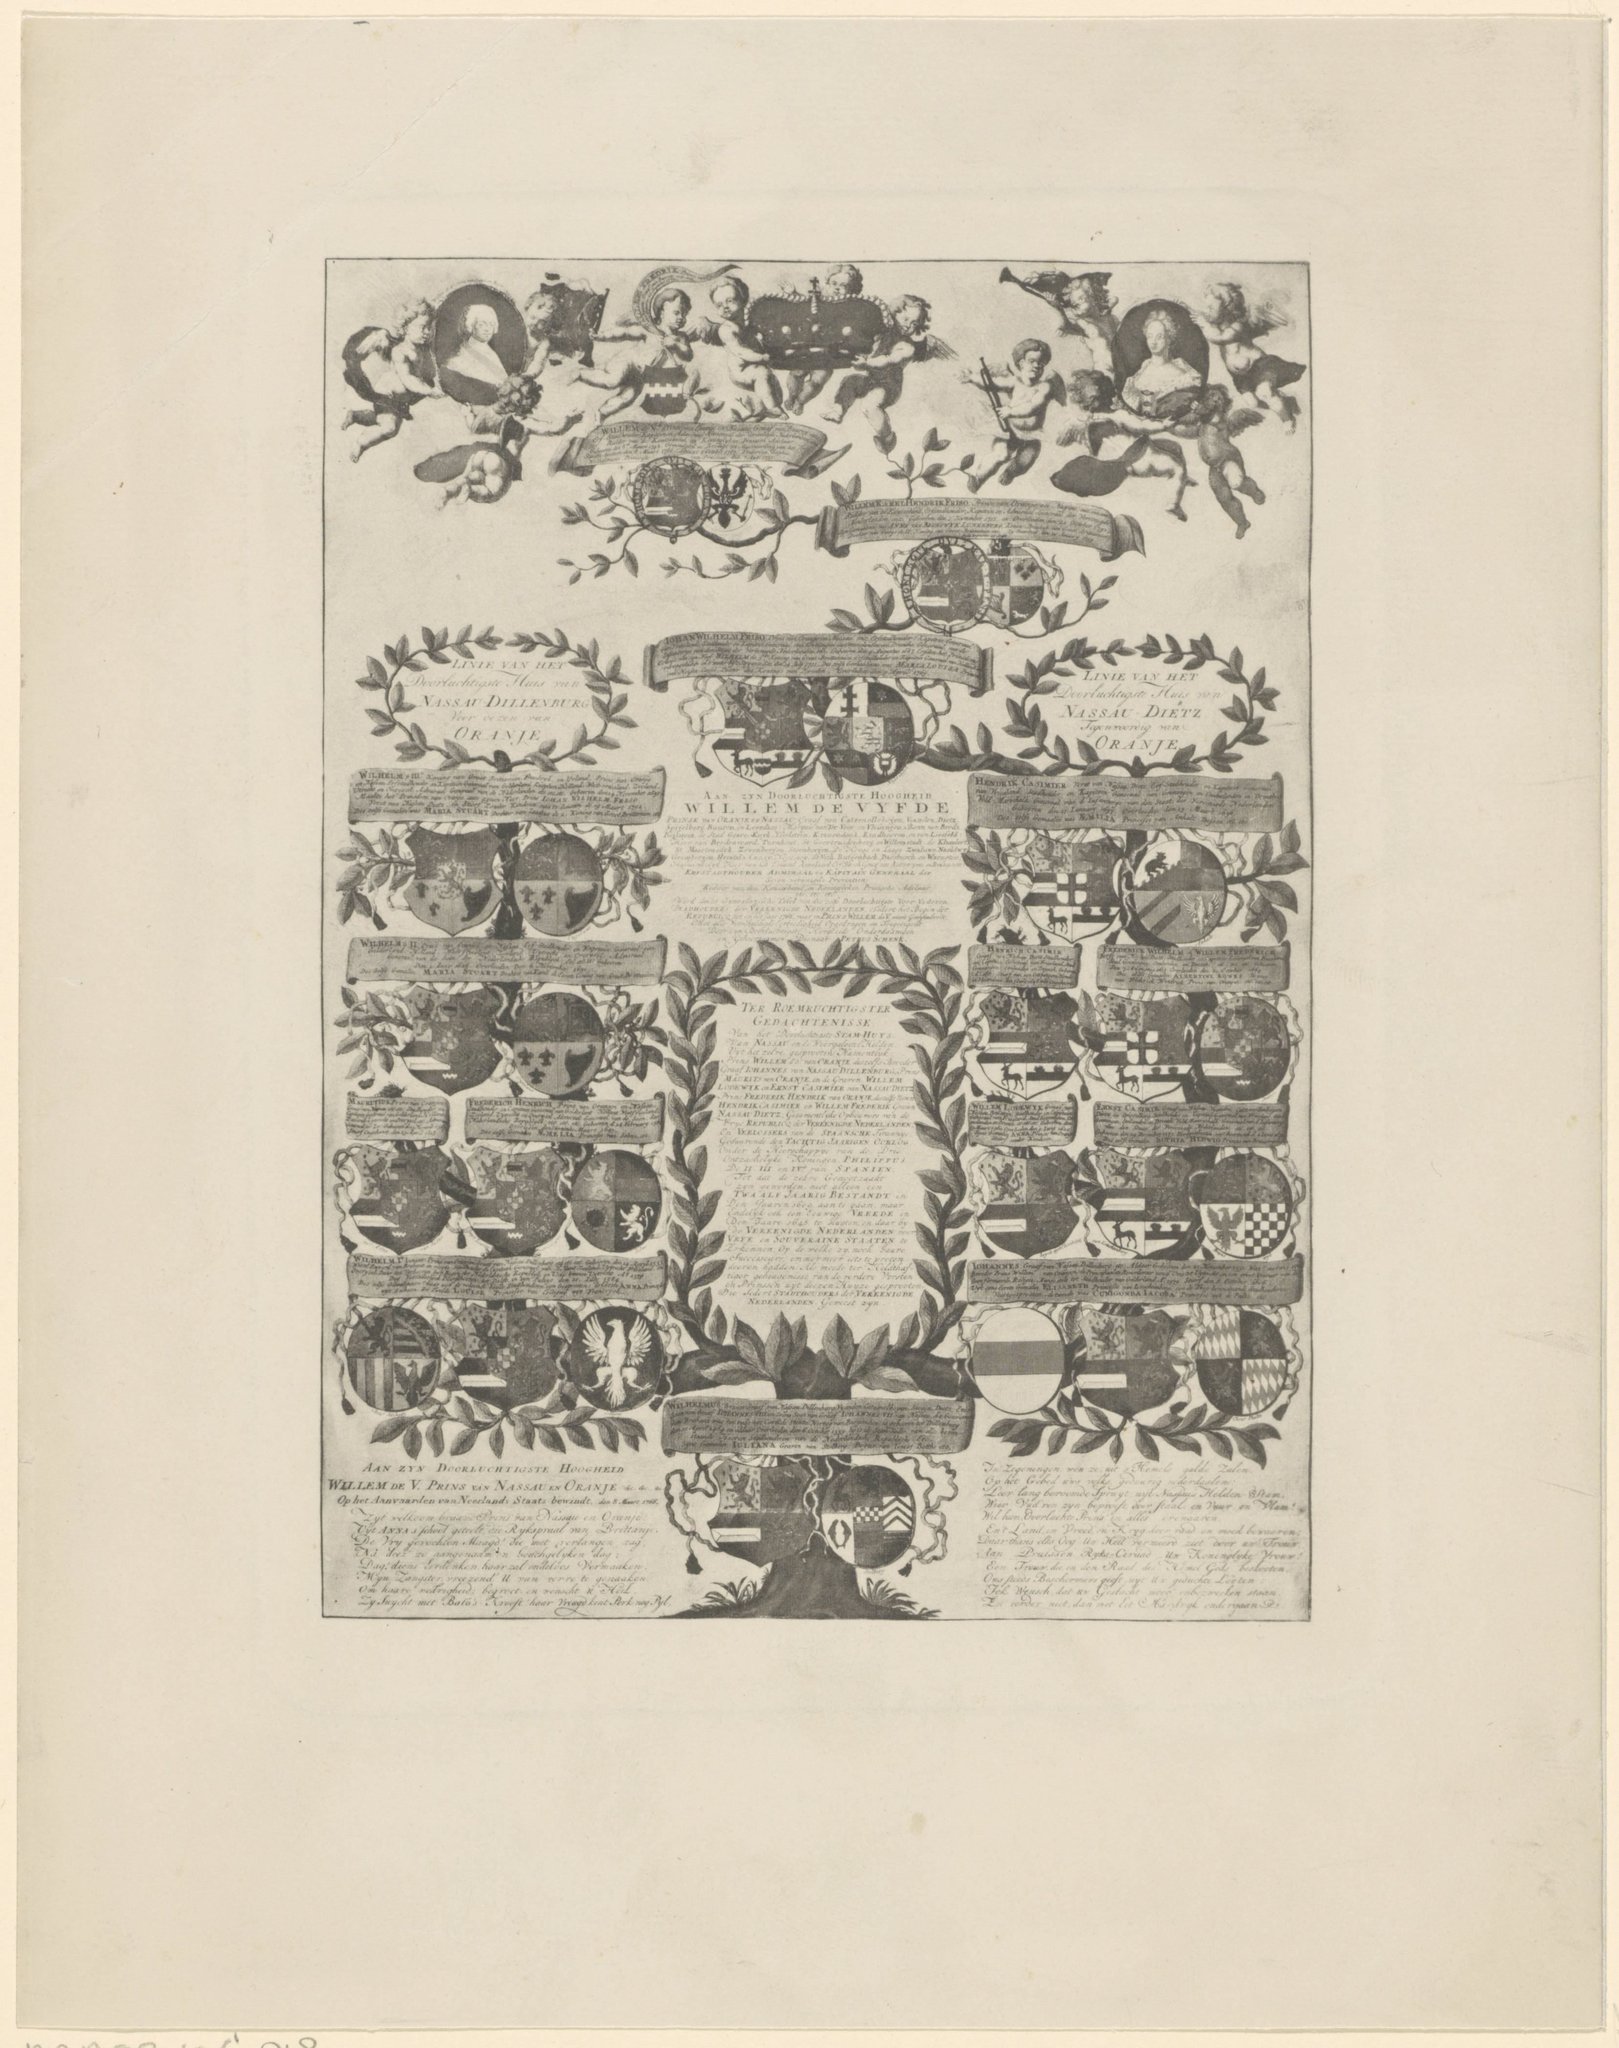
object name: photomechanical print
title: Stamboom van het Huis Oranje-Nassau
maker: Anonymous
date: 1850-1949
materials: paper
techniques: photograph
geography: netherlands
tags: louise de coligny, william iii (prince of orange and king of england, scotland, and ireland), delft, frederick henry (prince of orange), william ii (prince of orange), william i (prince of orange), maurice (prince of orange), maria ii stuart (koningin van engeland, schotland en ierland), amalia of solms-braunfels, london, mary henrietta stuart, the hague, willem iv (prins van oranje-nassau), anna van hannover, knighthood order (garter) - insignia of a knighthood order, e.g.: badge, chain, family lineage, pedigree, genealogical tree or table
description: Stamboom van het Huis Oranje-Nassau, van Willem I tot en met Willem IV. In het midden twee kolommen met Nederlandse tekst. Daar omheen meerdere wapens met in cartouches namen, titels, geboortedata en sterfdata. Linksonder en rechtsonder Nederlandse tekst.